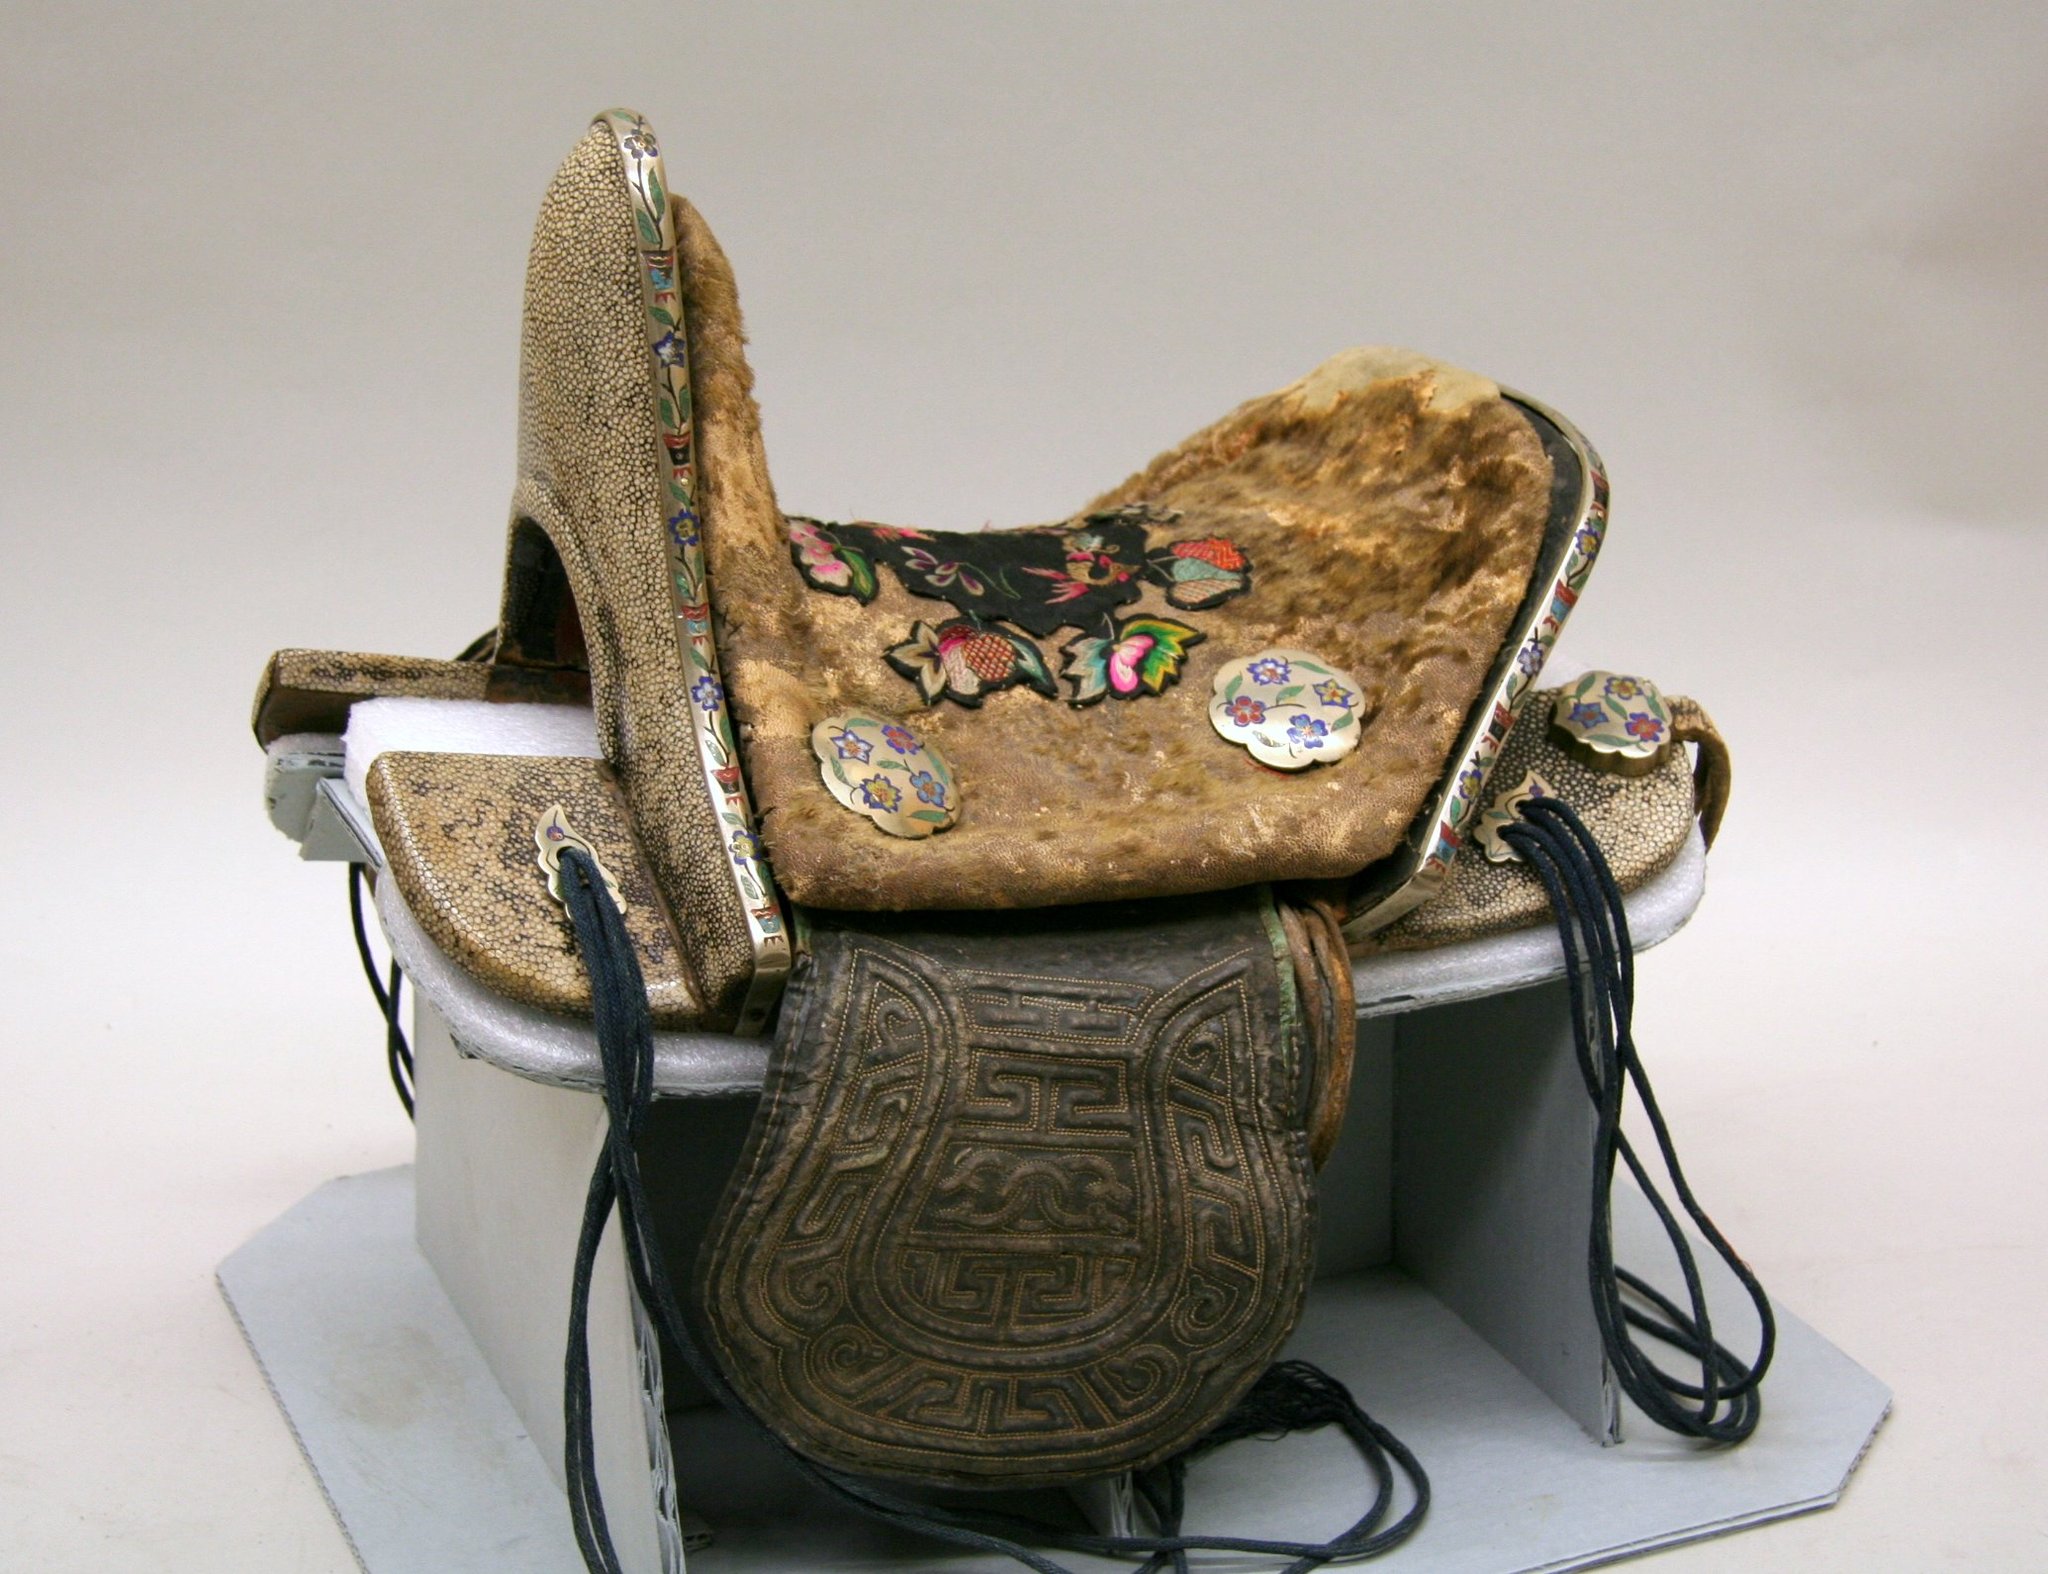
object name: saddle and bridle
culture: korean or mongol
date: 1801-1900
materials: cord, enamel, leather, silver, textile, wood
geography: korea